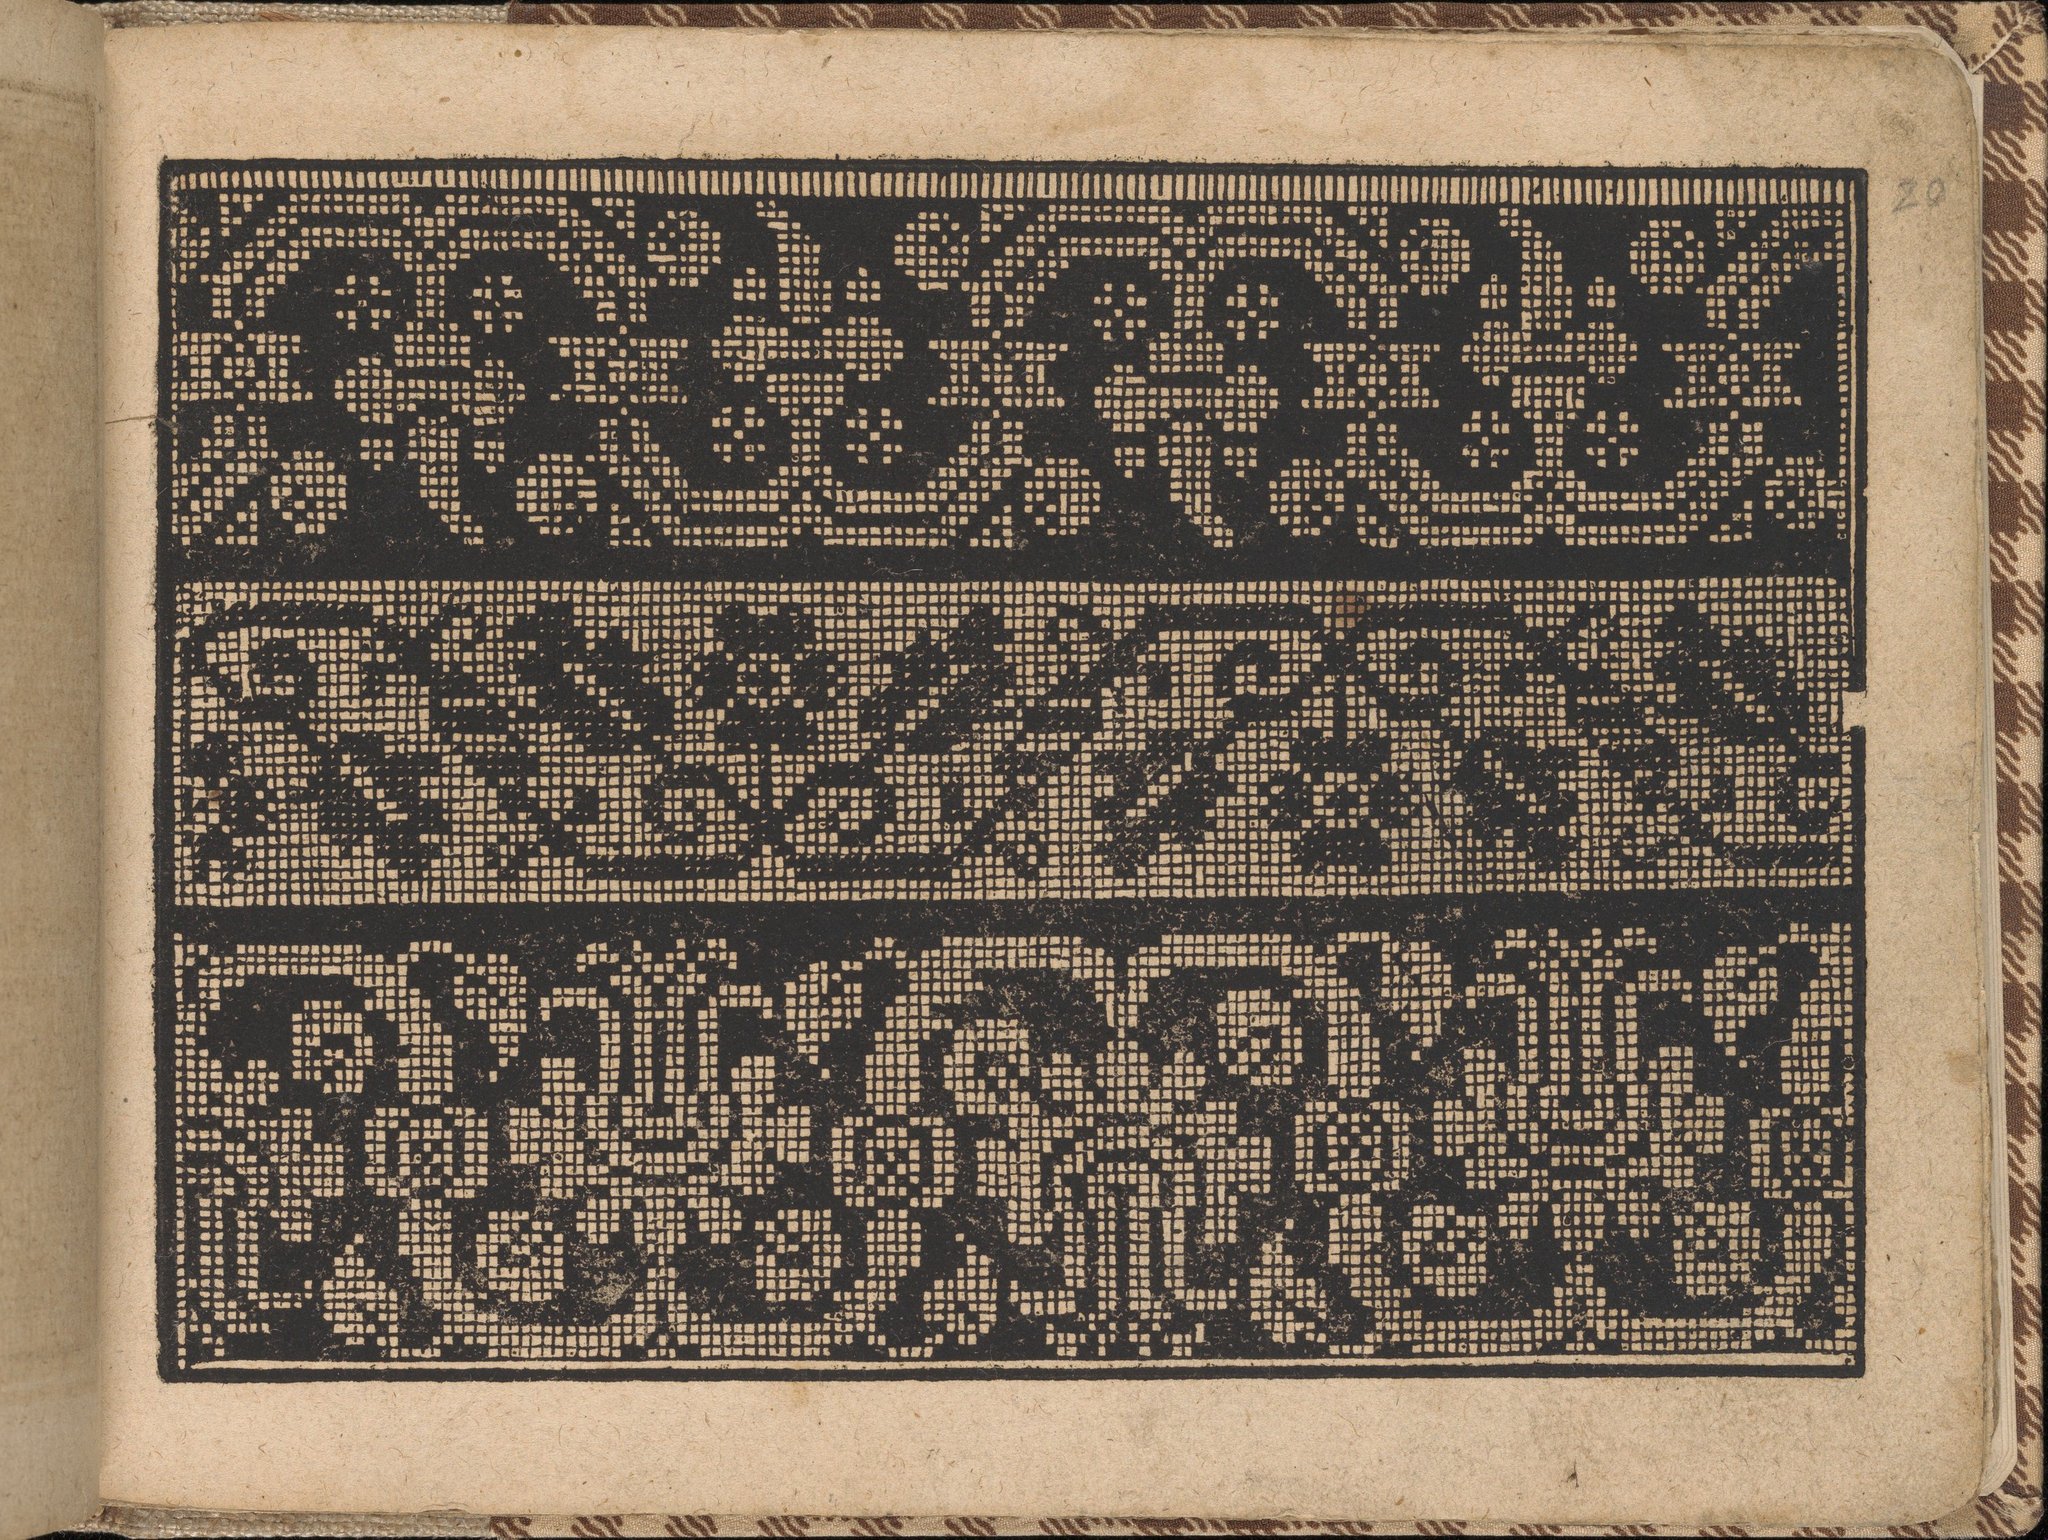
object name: book print ornament architecture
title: New Künstlichs Modelbuch (Page 20 recto)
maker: bernhard jobin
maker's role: publisher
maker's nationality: swiss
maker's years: 1535-1597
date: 1600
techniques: woodcut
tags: flowers